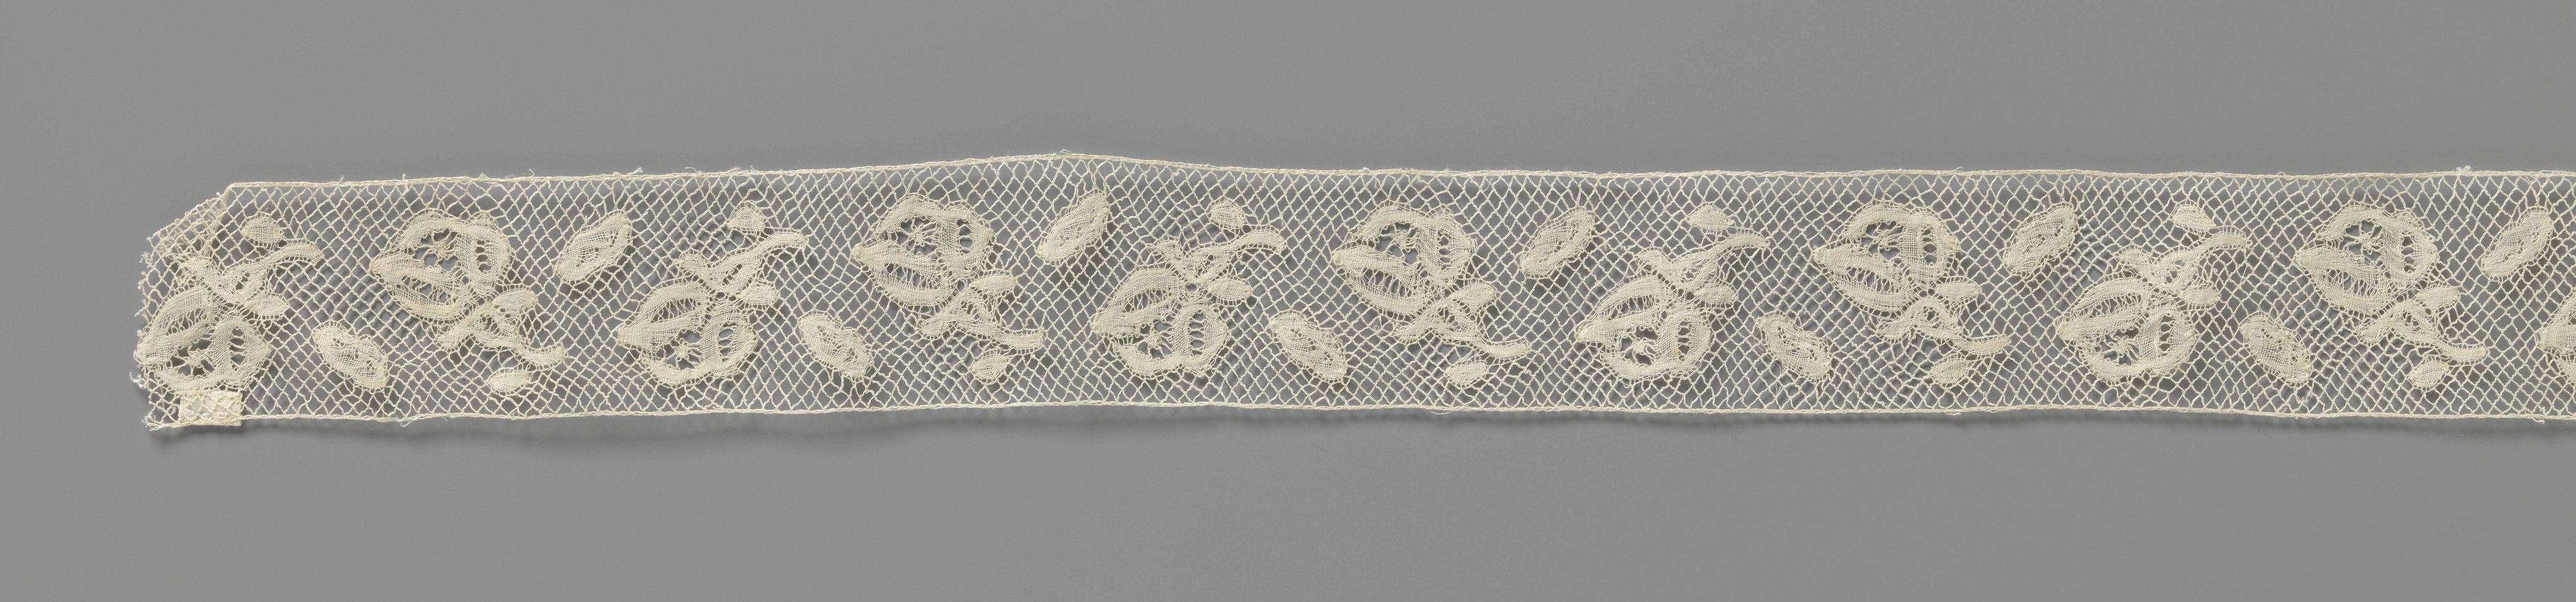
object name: entre deux, tussenzetsel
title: Tussenzetsel van kloskant met op- en neergaande rozen aan tak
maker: Anonymous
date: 1925-1930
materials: linen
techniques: lace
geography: netherlands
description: Een grof mazenfond (vierkante maas) is gevuld met los van elkaar staande en schuin op- en neergaande rozen aan een tak, afgewisseld door een opwaaiend blad. Valenciennes.